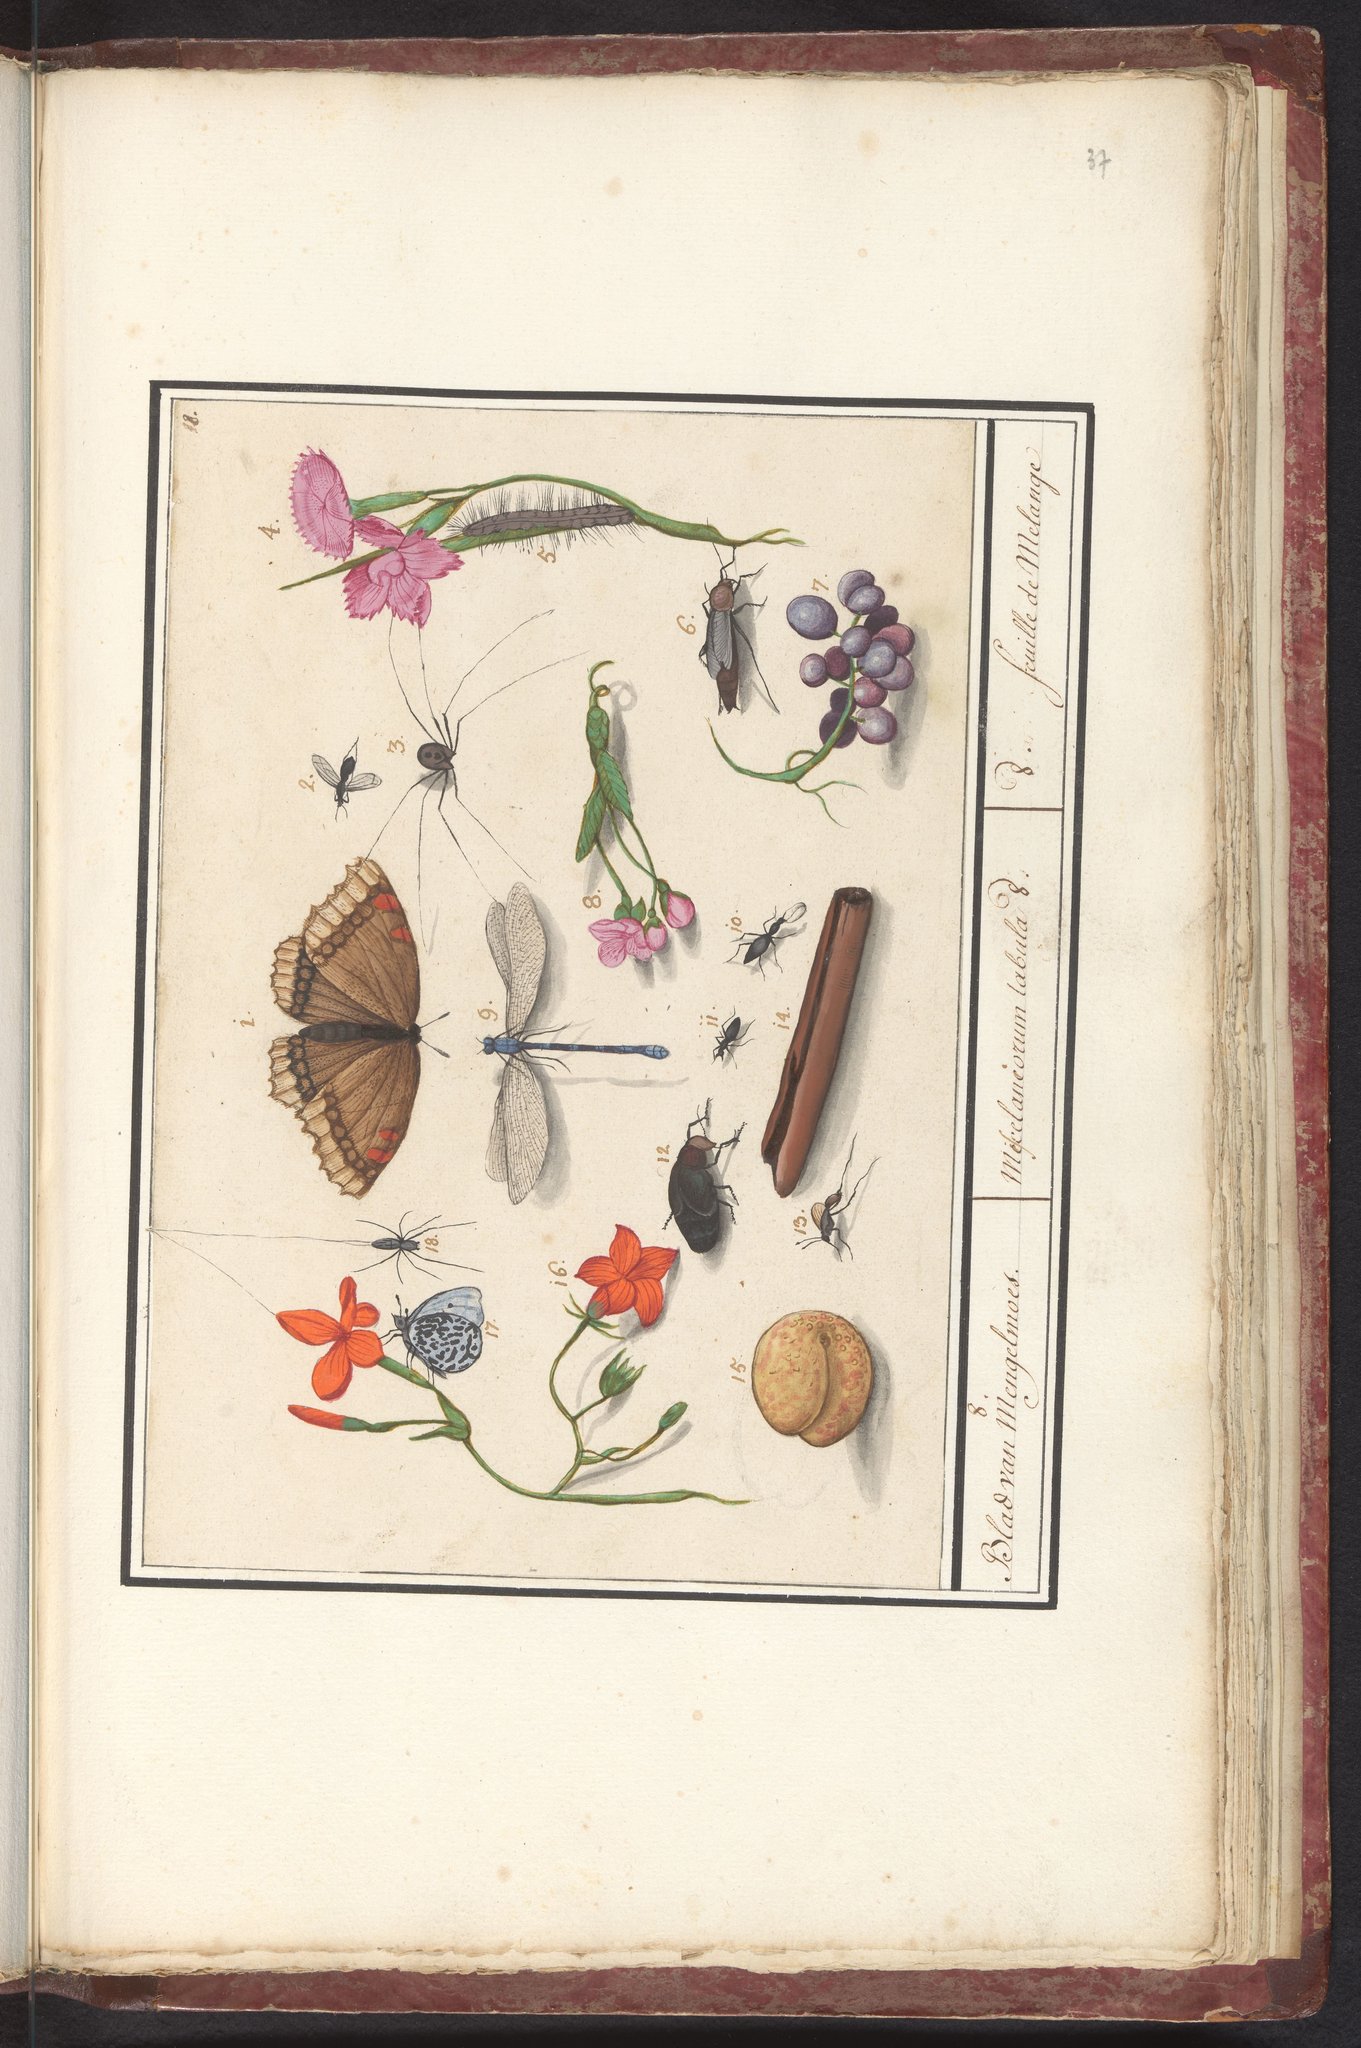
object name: drawing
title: Natuurhistorische ensemble (nr. 8)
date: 1596-1610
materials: chalk, paint, ink, lacquer, paper, pencil, watercolor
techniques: brush, pen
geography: prague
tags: flowers, insects: dragon-fly, (non-fruit) products of plants or trees: cinnamon, spiders, insects: butterfly, insects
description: Blad met de achtste natuurhistorische ensemble met dieren en planten, nummers 1-18. Insecten (libel, vlieg, vlinders), spinnen, vruchten, bloemen en een stuk hout of bast (mogelijk kaneel). Genummerd rechtsboven: 8. Onderdeel van het zevende album met tekeningen van reptielen, amfibieën en natuurhistorische ensembles. Het zevende van twaalf albums met aquarellen van dieren, vogels en planten bekend rond 1600, gemaakt in opdracht van keizer Rudolf II. Met toelichting in Nederlands, Latijn en Frans.